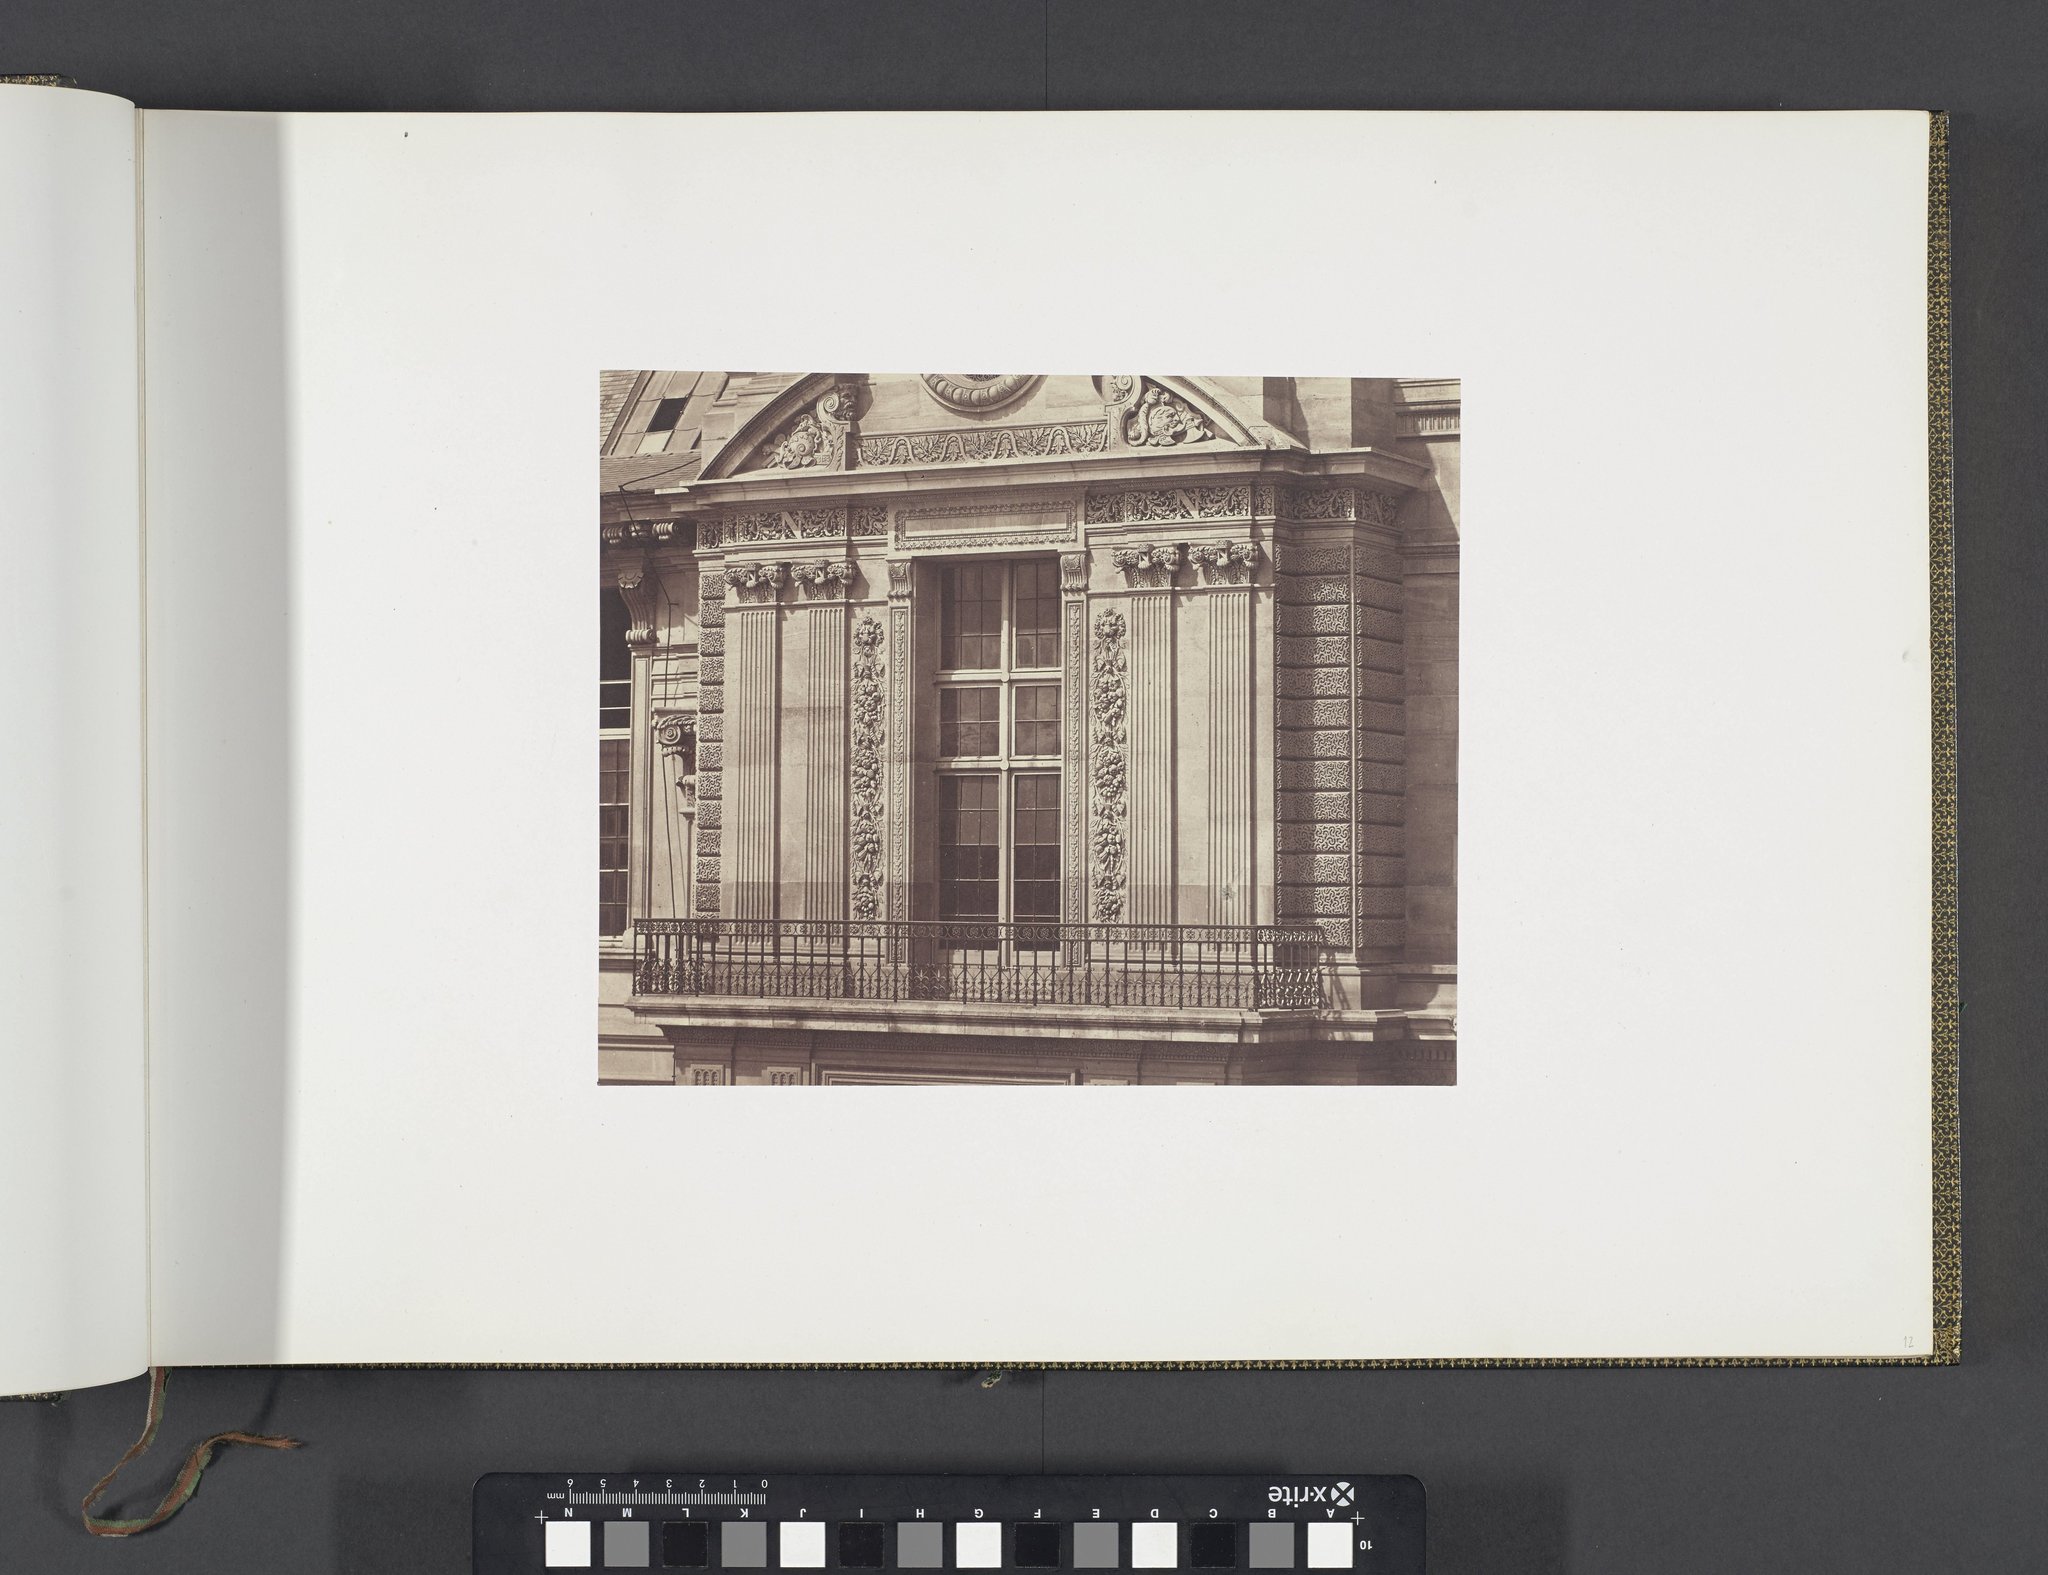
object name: album leaf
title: Gevel van het Pavillon de Rohan (onderzijde)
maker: édouard denis baldus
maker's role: fotograaf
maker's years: 1813-1889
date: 1857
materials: paper, photographic support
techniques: salted paper print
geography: paris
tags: tower, clock tower ~ monumental adornment, permanent exhibition, museum, paris, tuileries palace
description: Onderdeel van Réunion des Tuileries au Louvre 1852-1857, album 1.